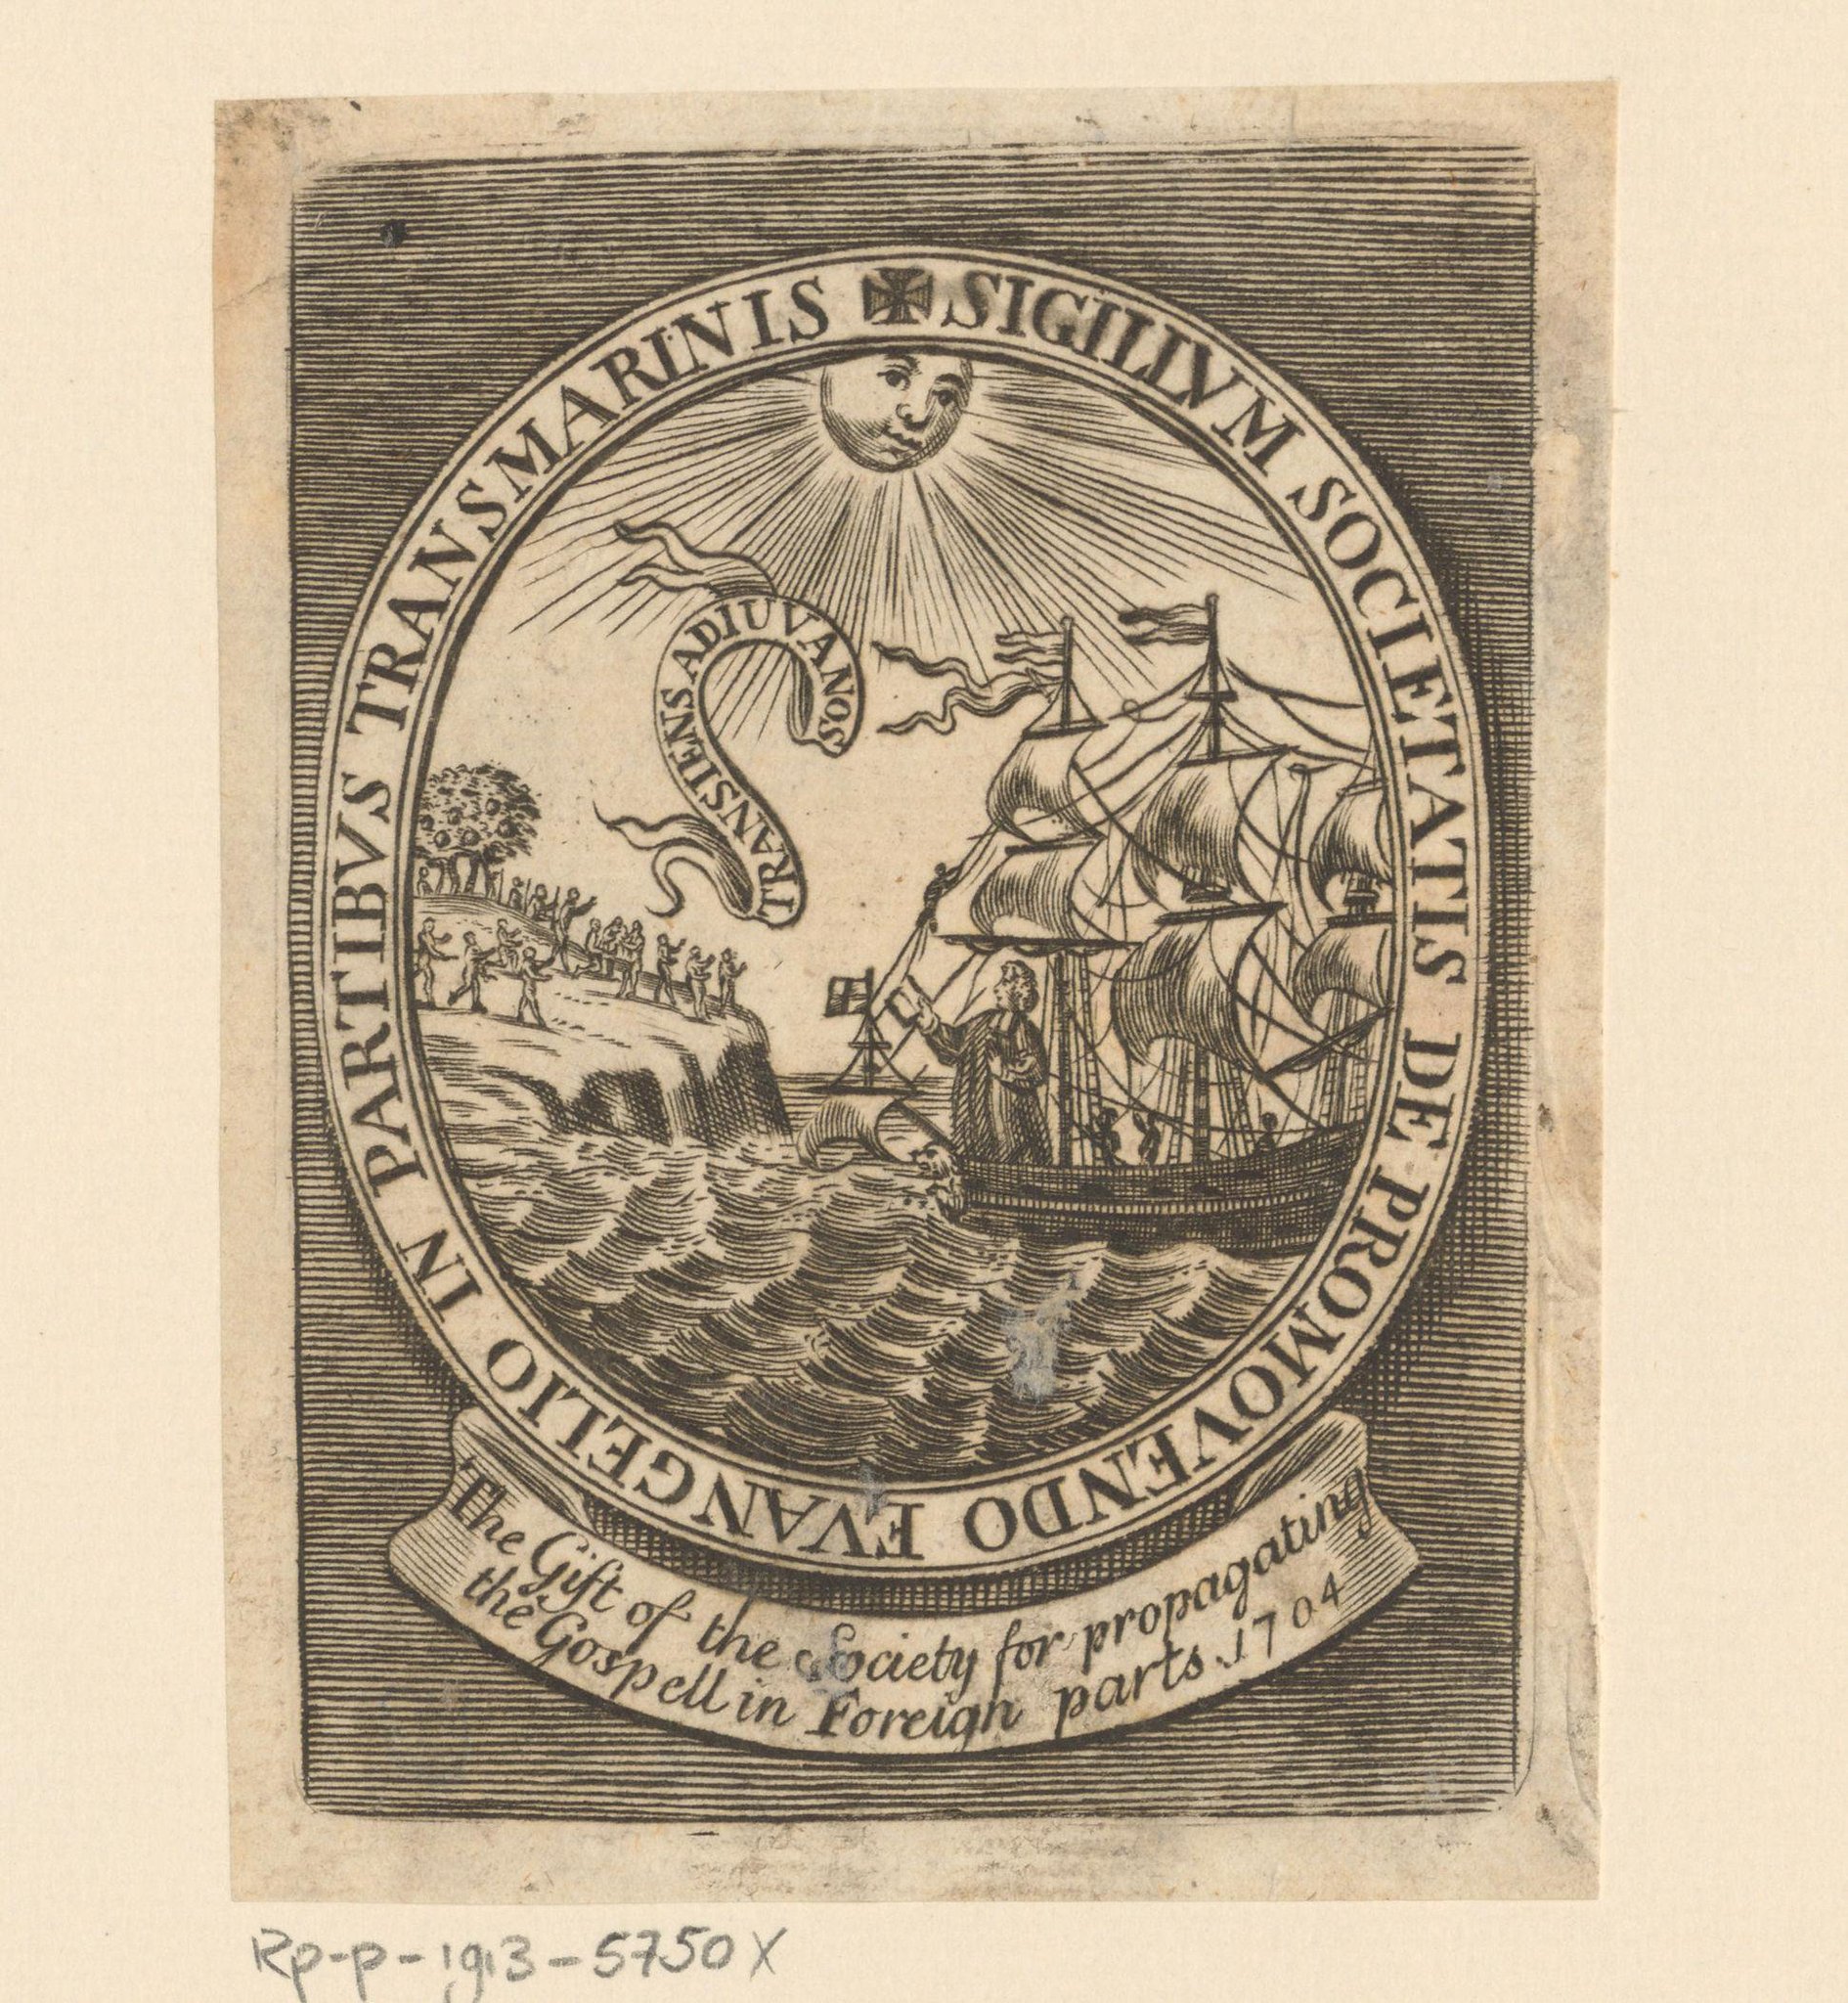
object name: bookplate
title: Ex libris van The Gift of the Society for Propagating the Gospell in Foreign Parts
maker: Anonymous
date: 1704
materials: paper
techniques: engraving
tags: missionary, spreading the gospel; missionary work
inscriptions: collector's mark: Lugt 2760, collector's mark: Lugt 2233